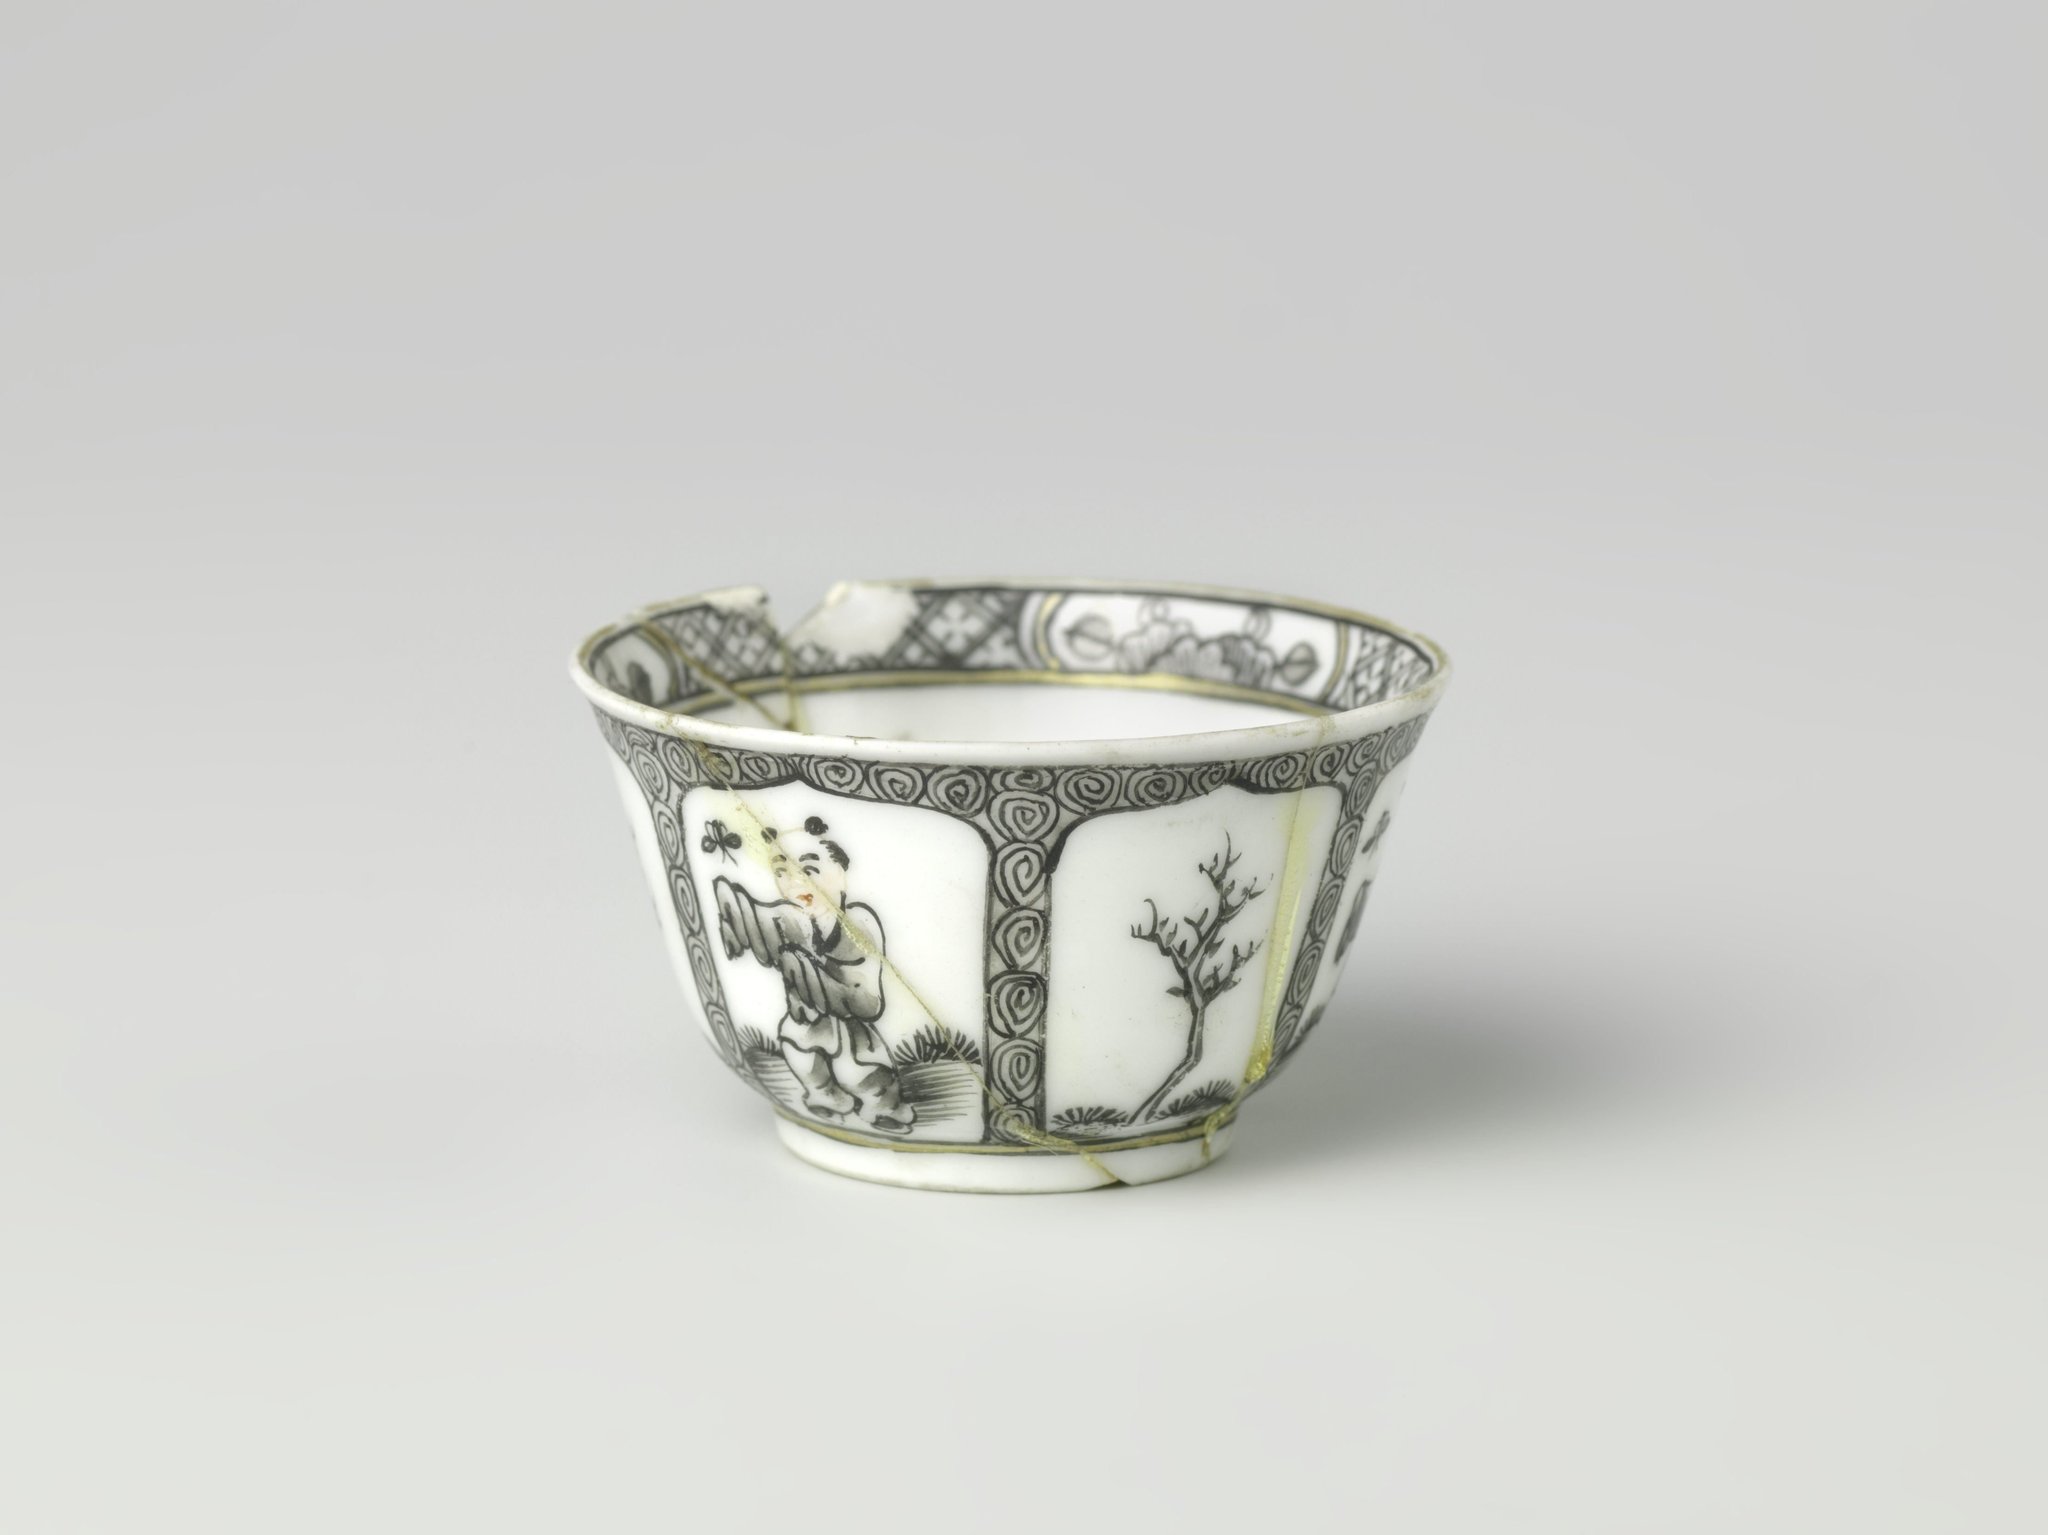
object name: cup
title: Cup with a boy and a butterfly in a landscape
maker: Anonymous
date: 1725-1749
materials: glaze, gold, paint, porcelain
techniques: firing, gilding, turning, vitrification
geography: china